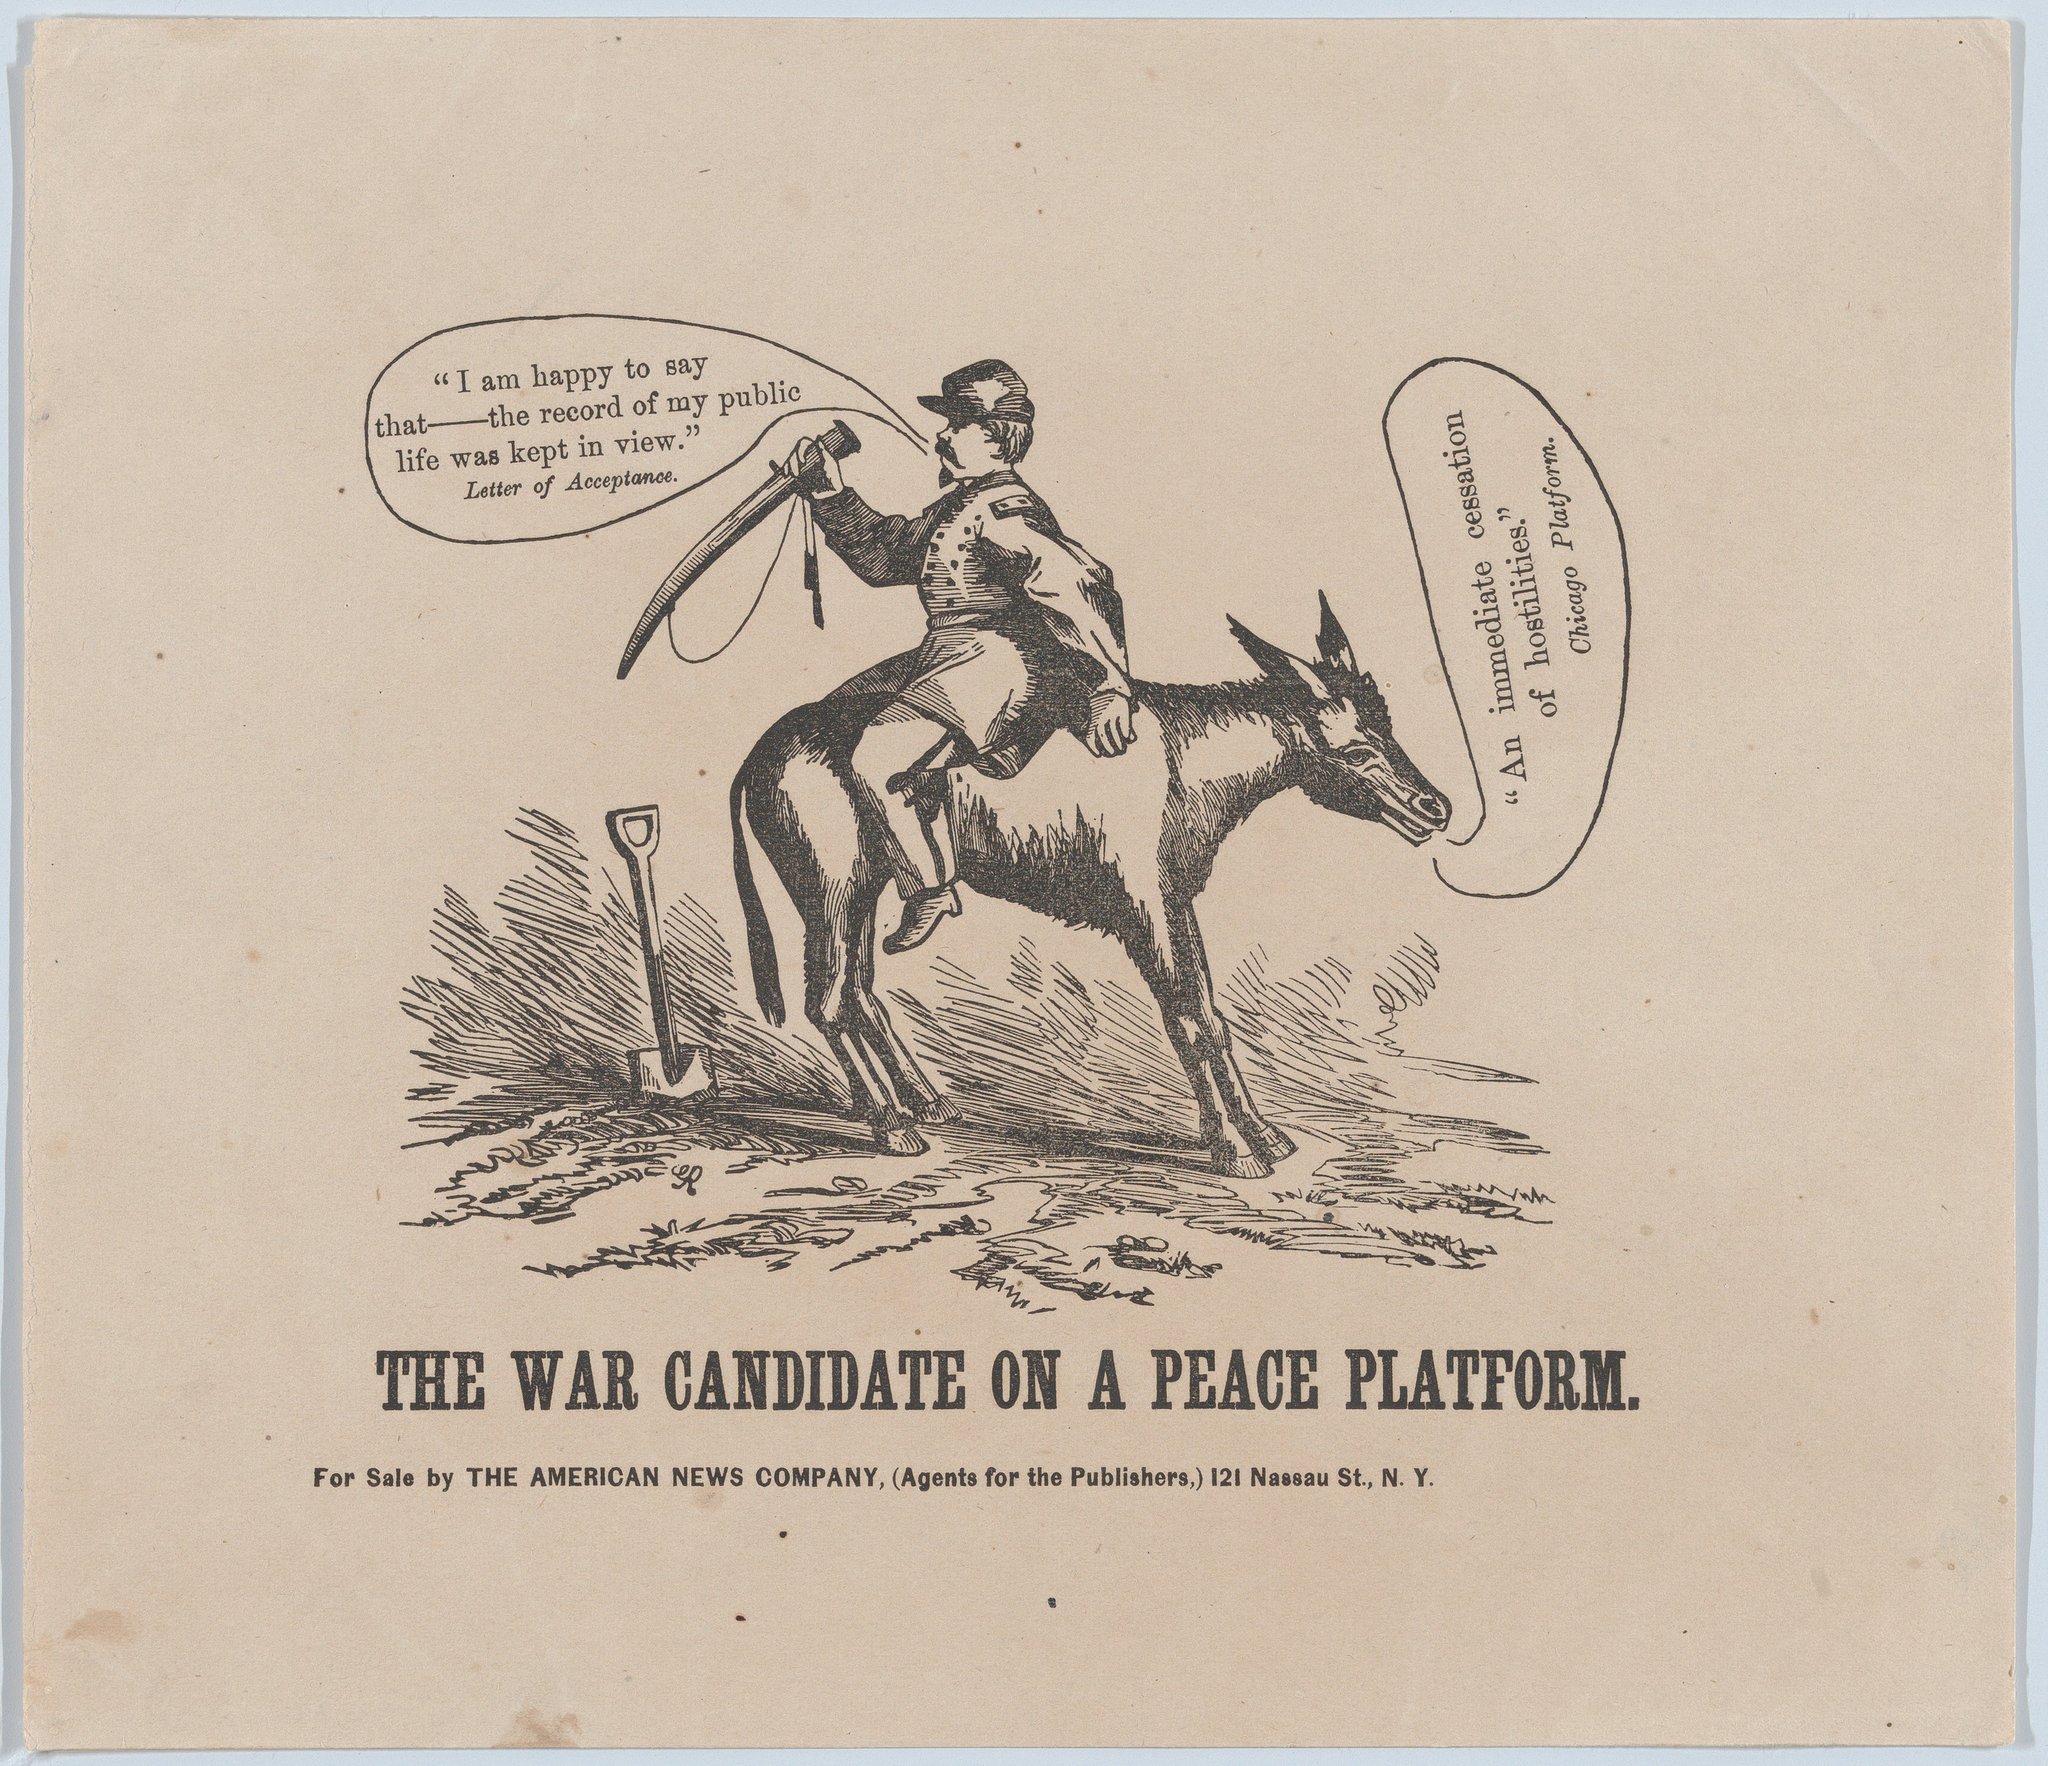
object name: print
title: The War Candidate on a Peace Platform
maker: anonymous, american, 19th century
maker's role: artist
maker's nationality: american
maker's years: 1800-1900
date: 1864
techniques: lithograph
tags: satire,men,donkeys,politics